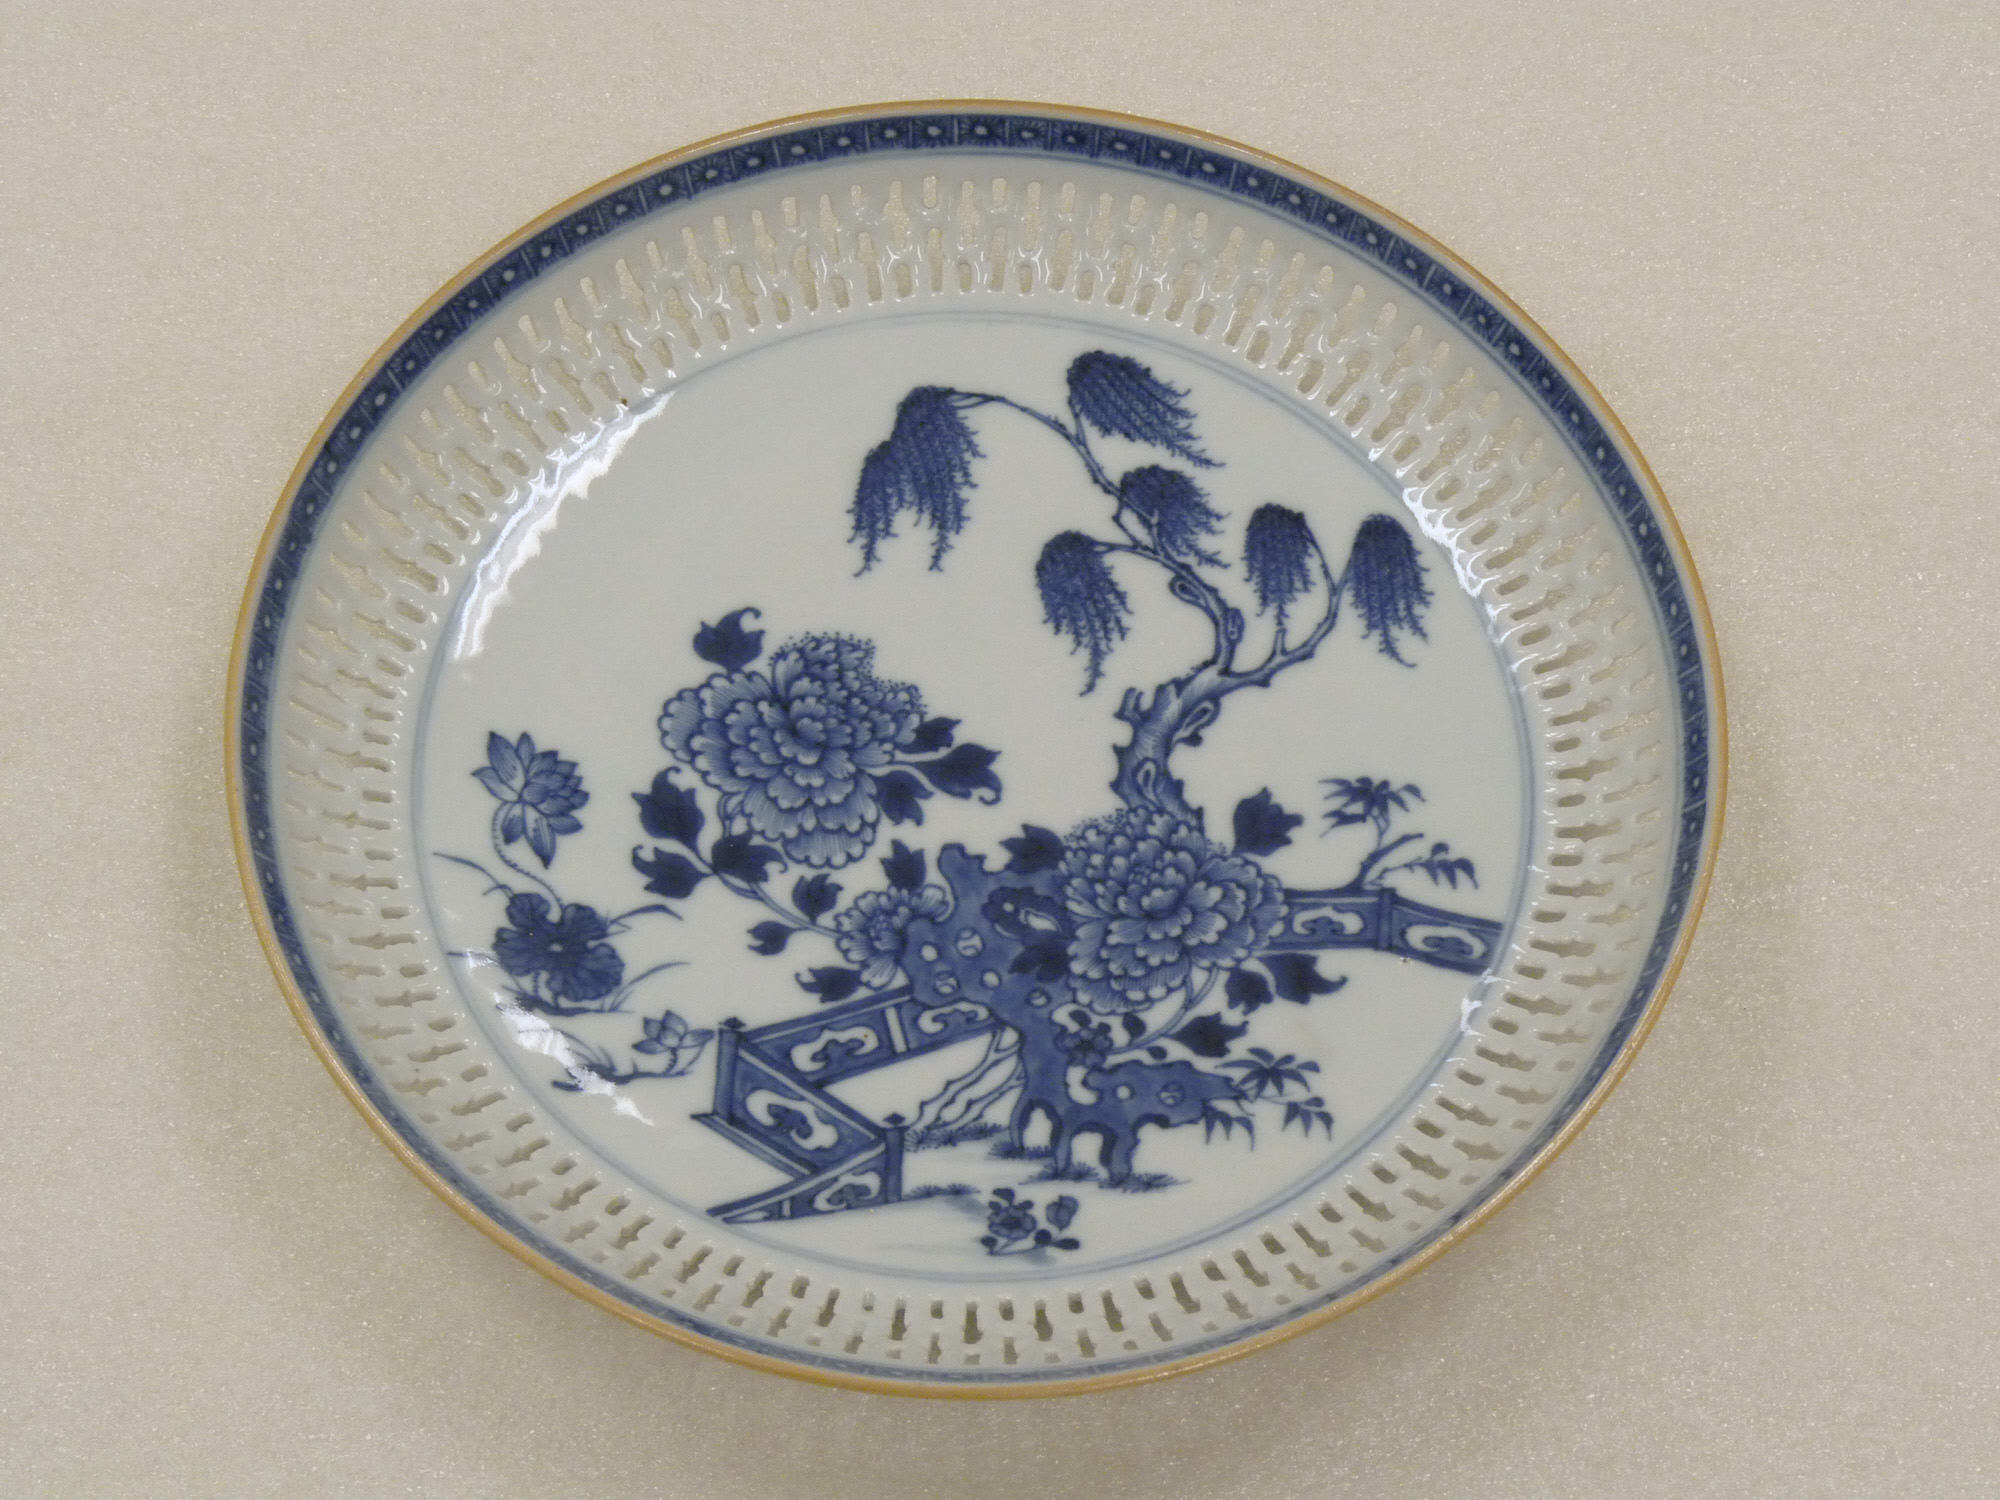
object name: dish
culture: chinese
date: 1736-1795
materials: porcelain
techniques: painting, underglaze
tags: flowers,trees